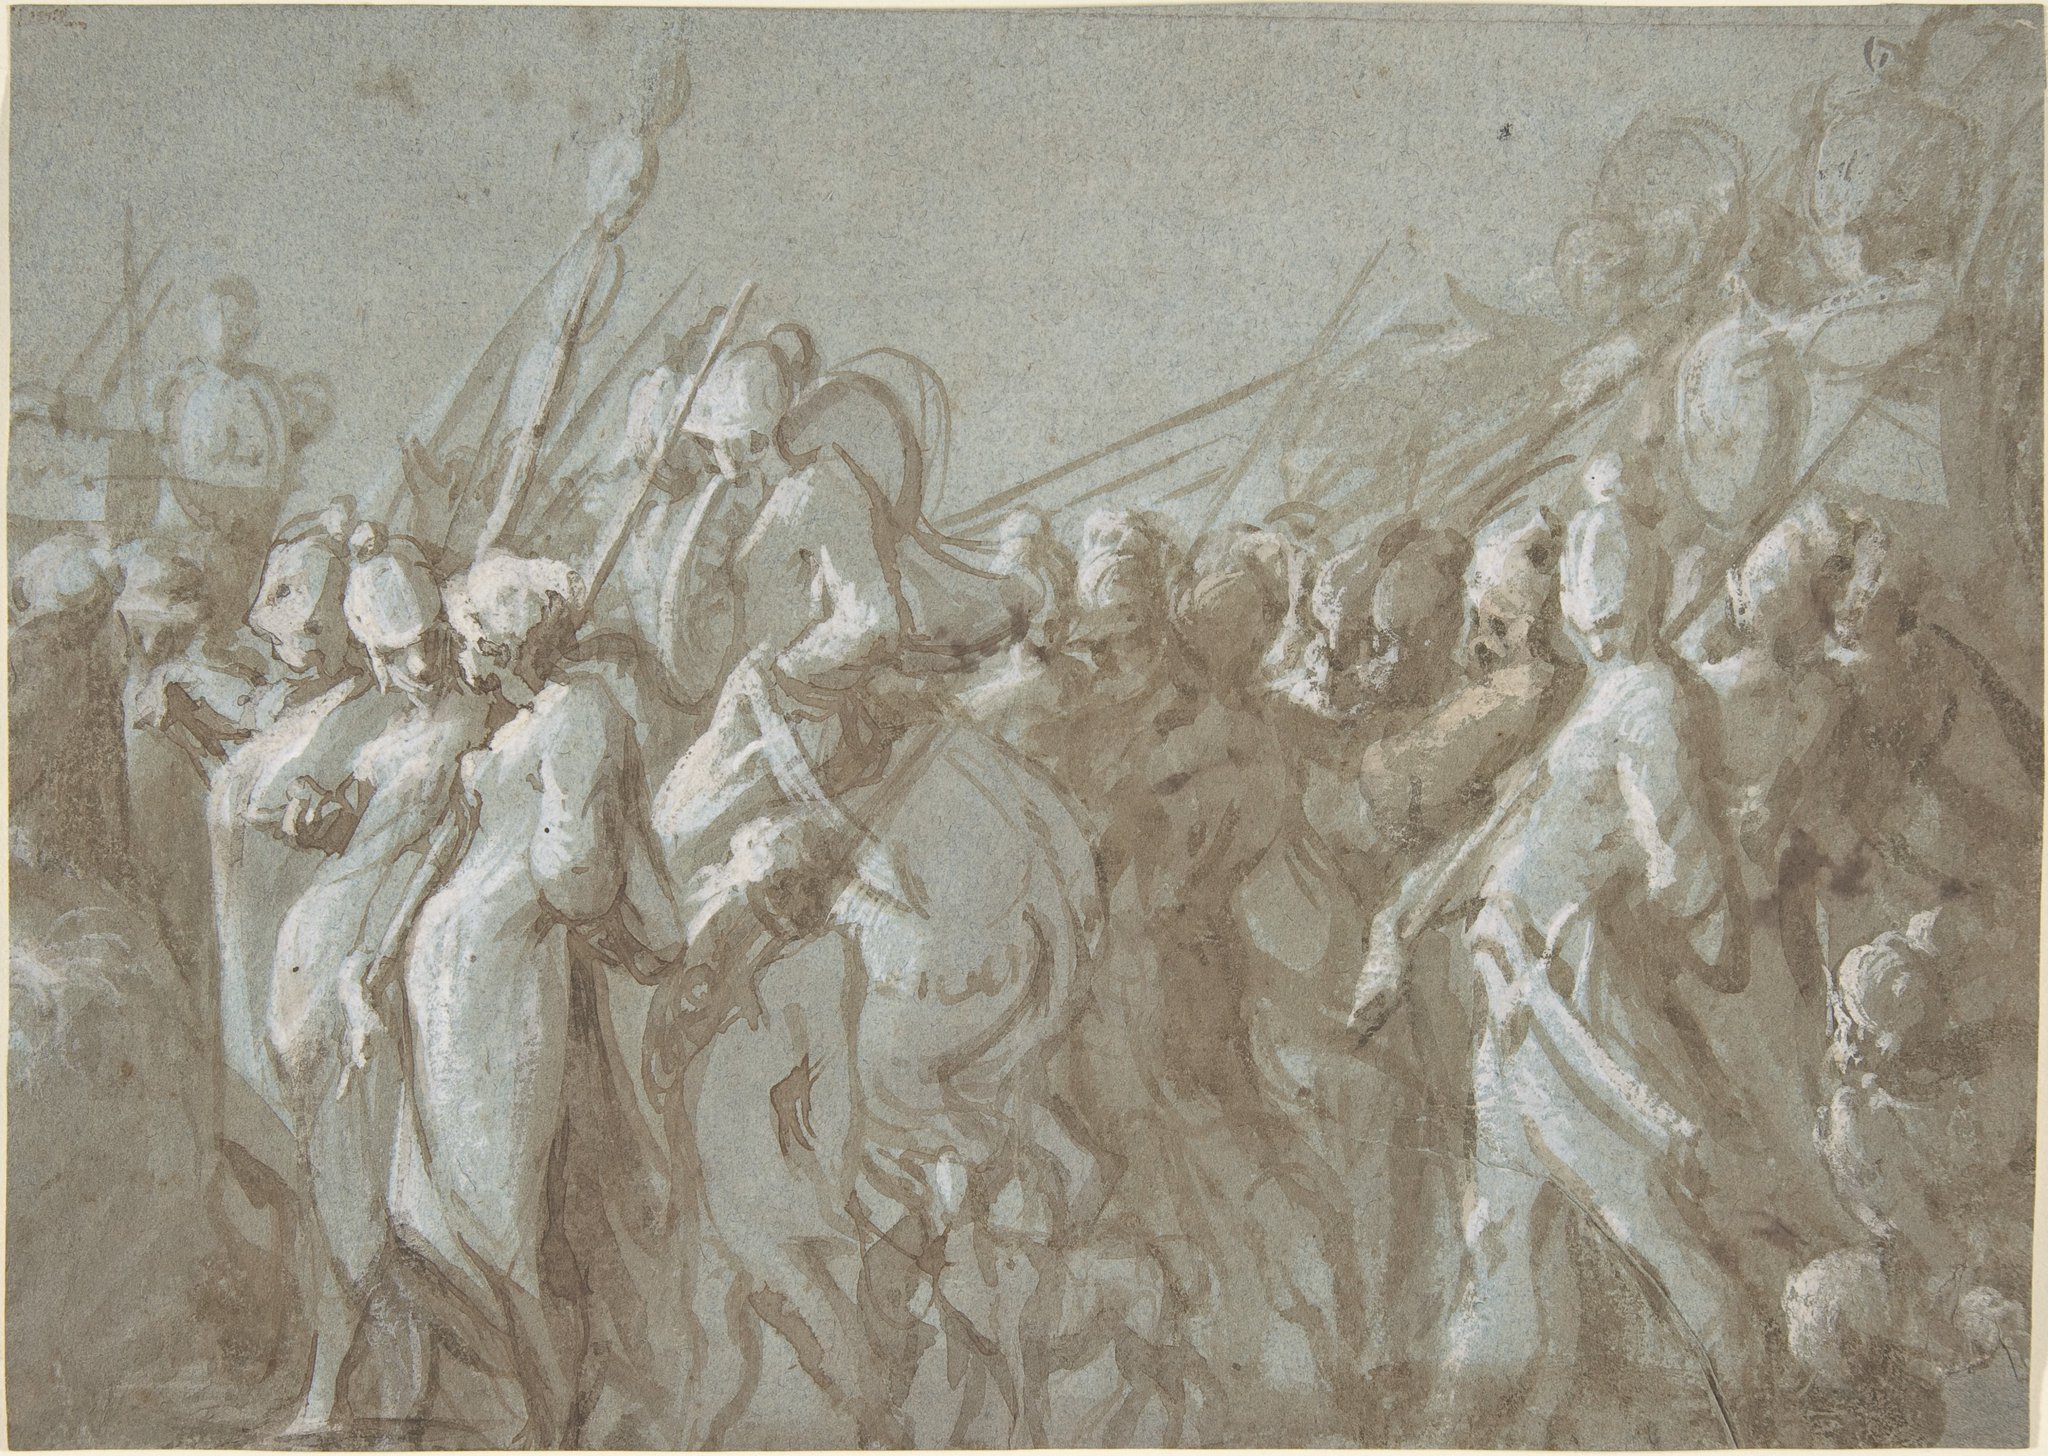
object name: drawing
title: Military Procession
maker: hans mont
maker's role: artist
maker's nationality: flemish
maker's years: 1545-1585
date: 1501-1600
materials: paint, ink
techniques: brush, heightening, pen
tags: military,weapons,crowd